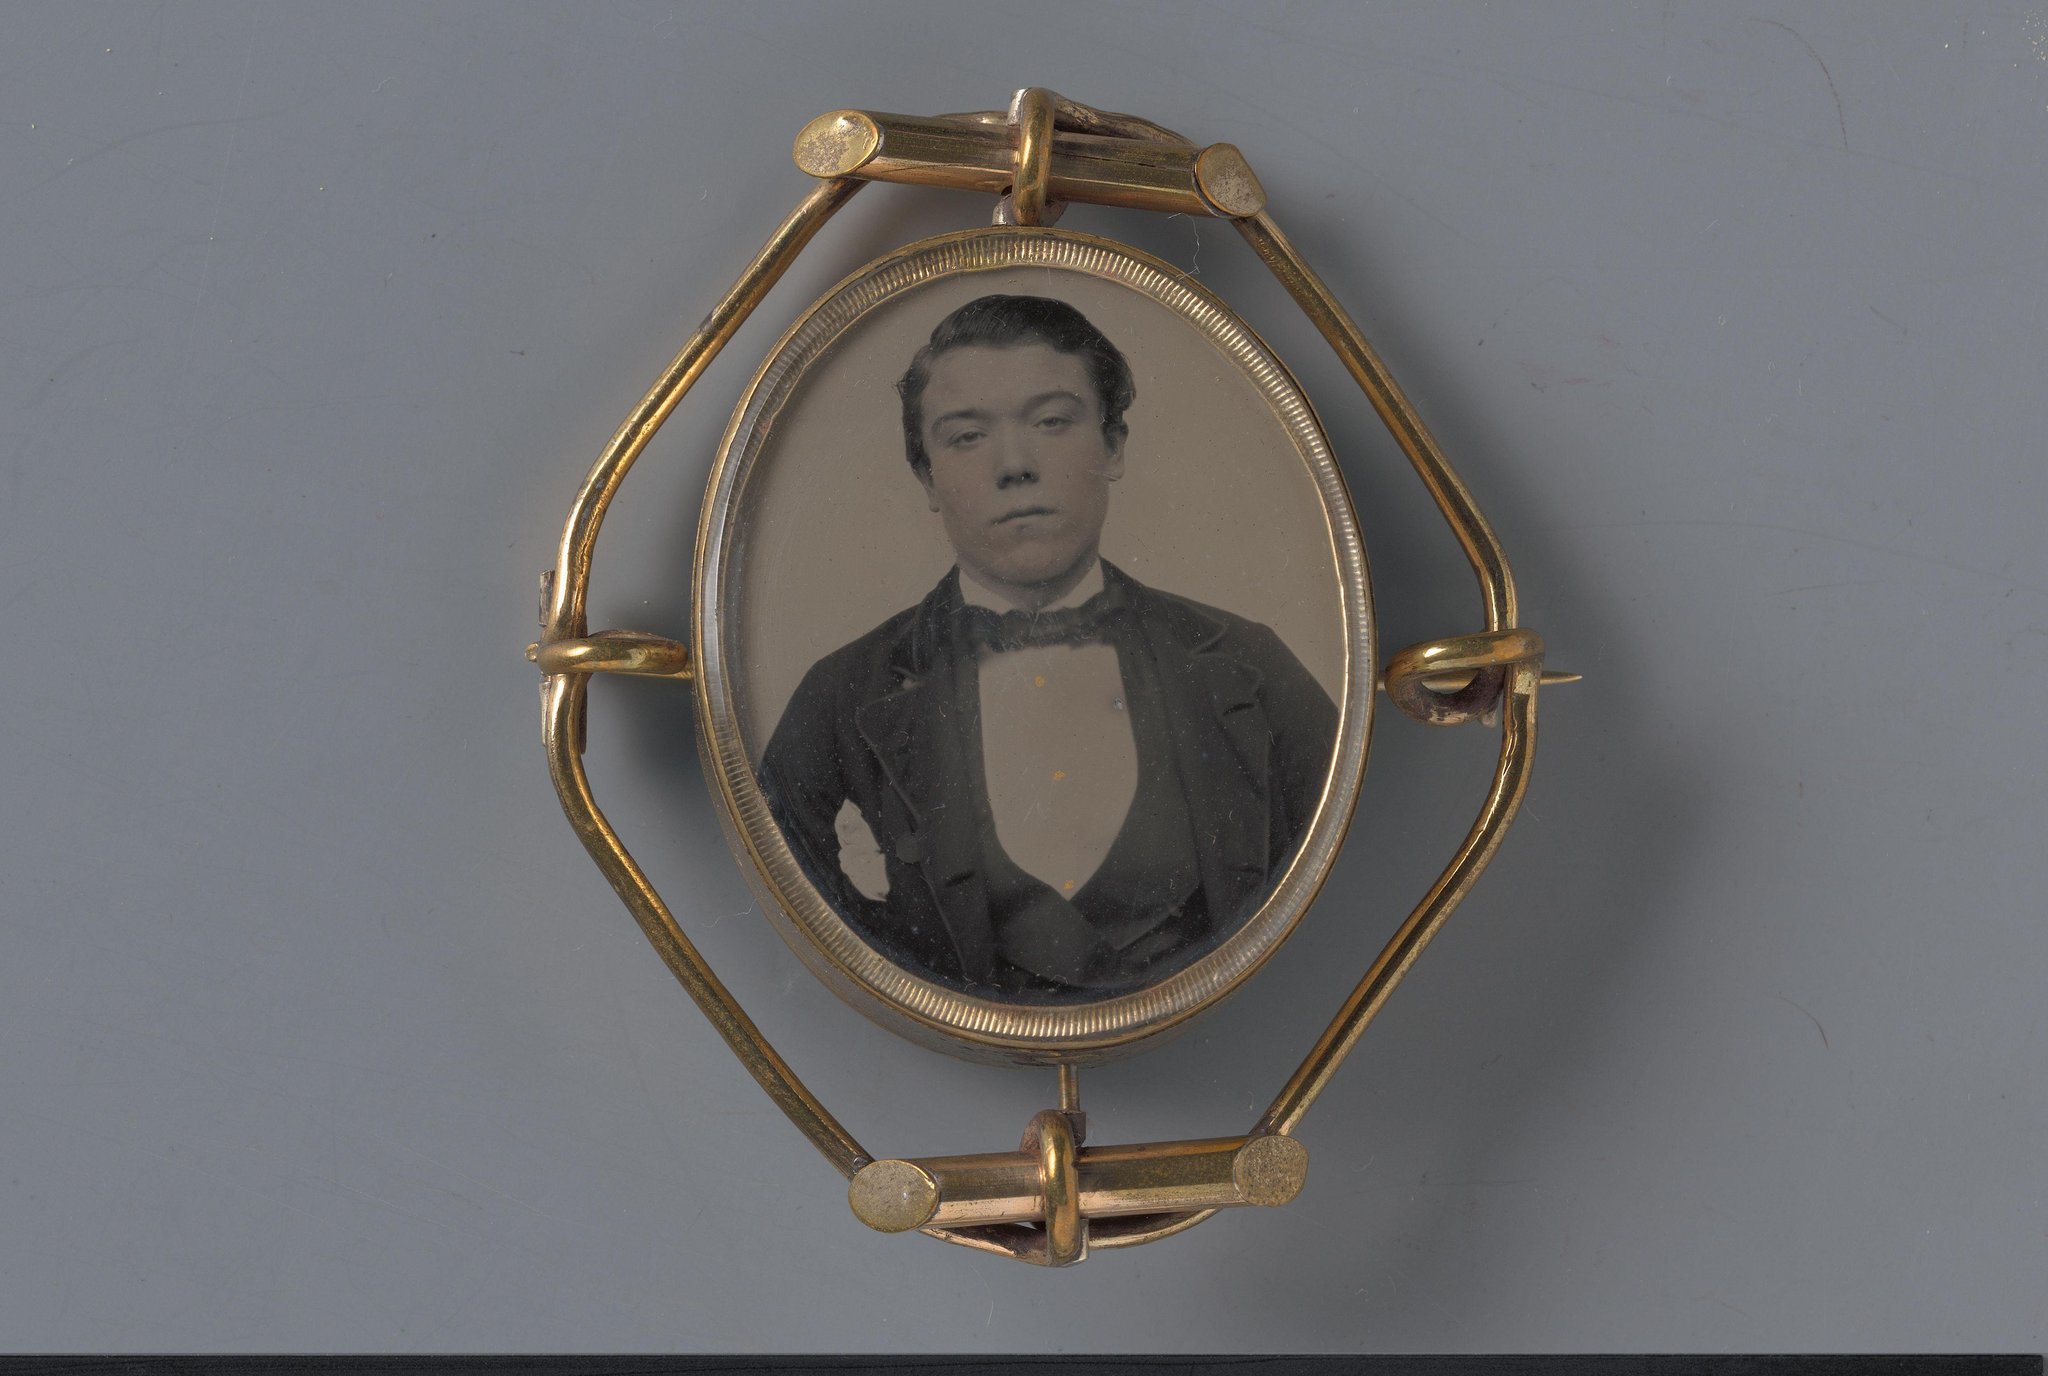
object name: photograph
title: Portret van een onbekende man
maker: Anonymous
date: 1860-1870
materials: glass, hair, metal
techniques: ambrotype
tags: historical persons